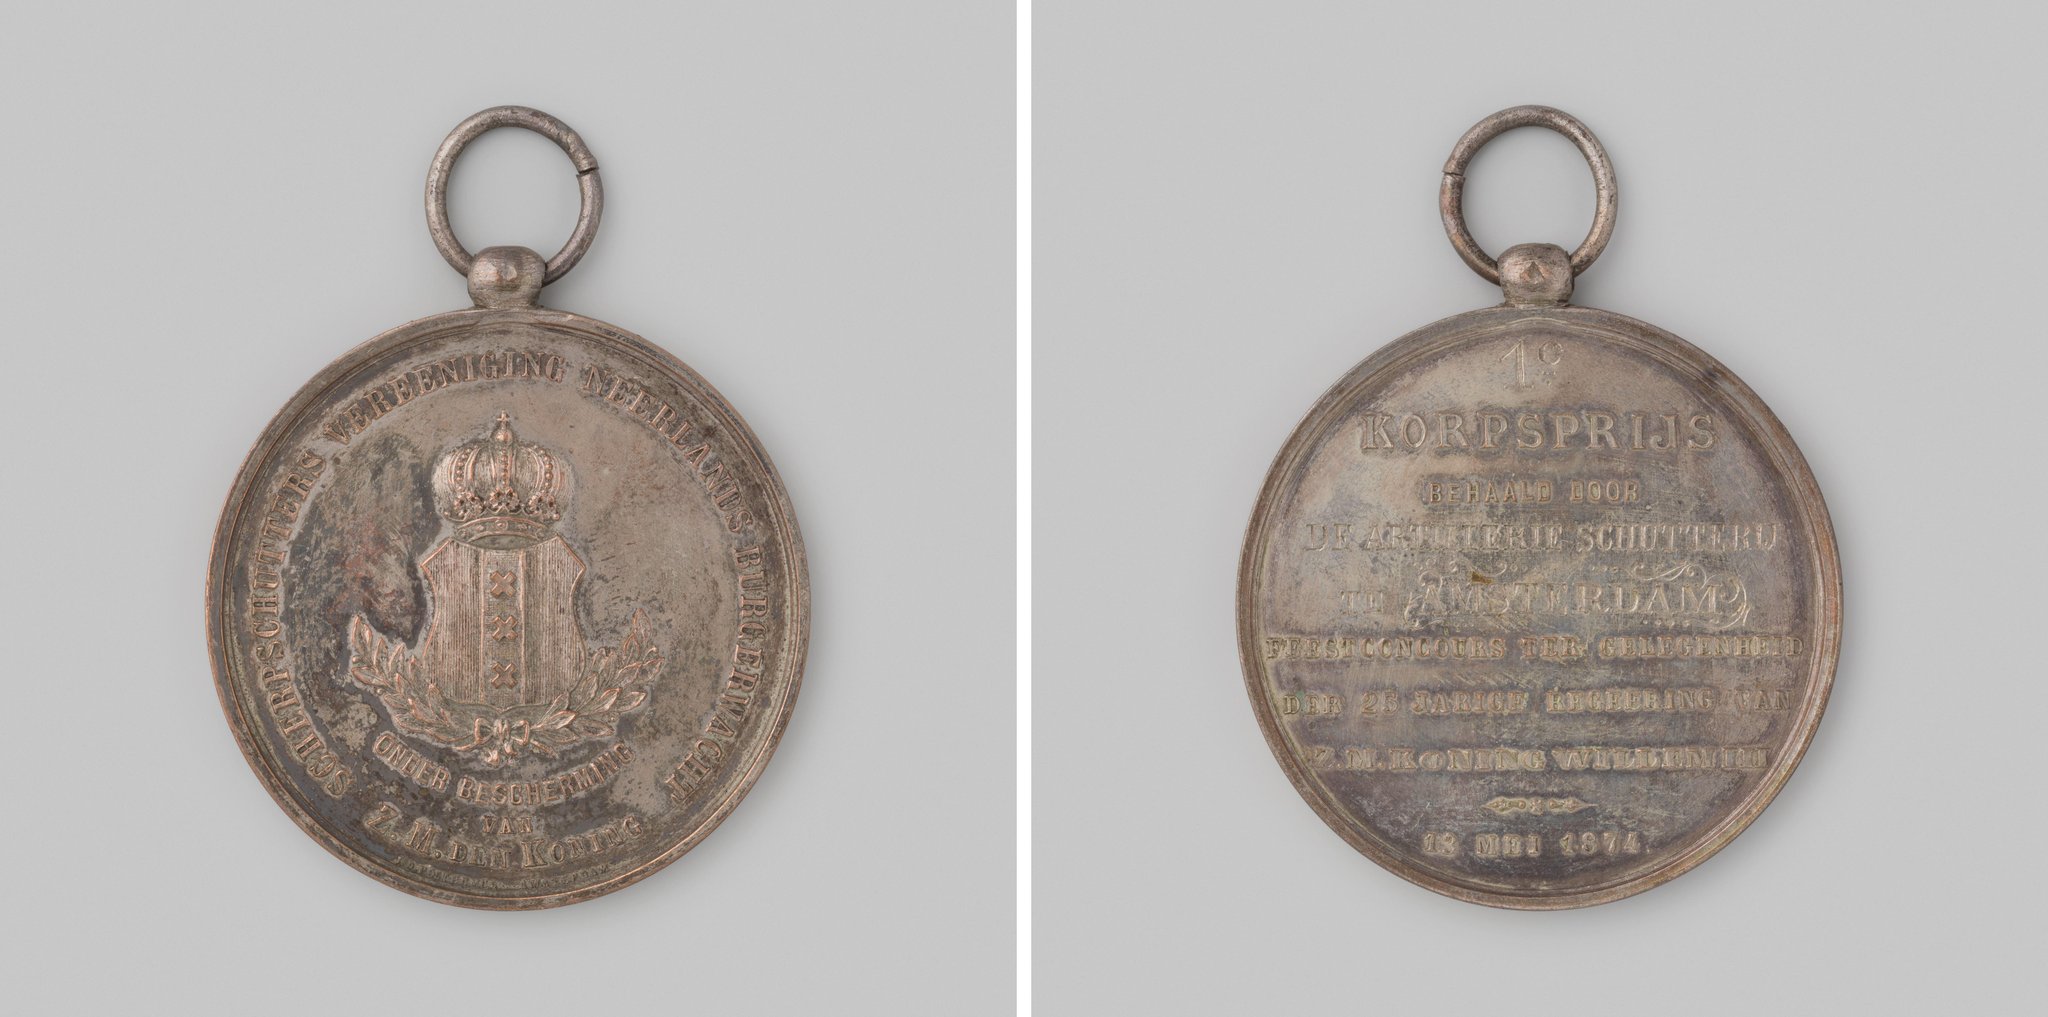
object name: medal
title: Prijspenning van de Scherpschuttersvereeniging Neerlands Burgerwacht, behaald door de artillerie schutterij te Amsterdam, eerste prijs voor Individueel-vuur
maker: jan daniel posthumus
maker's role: medailleur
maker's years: 1838-1919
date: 1894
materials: silver